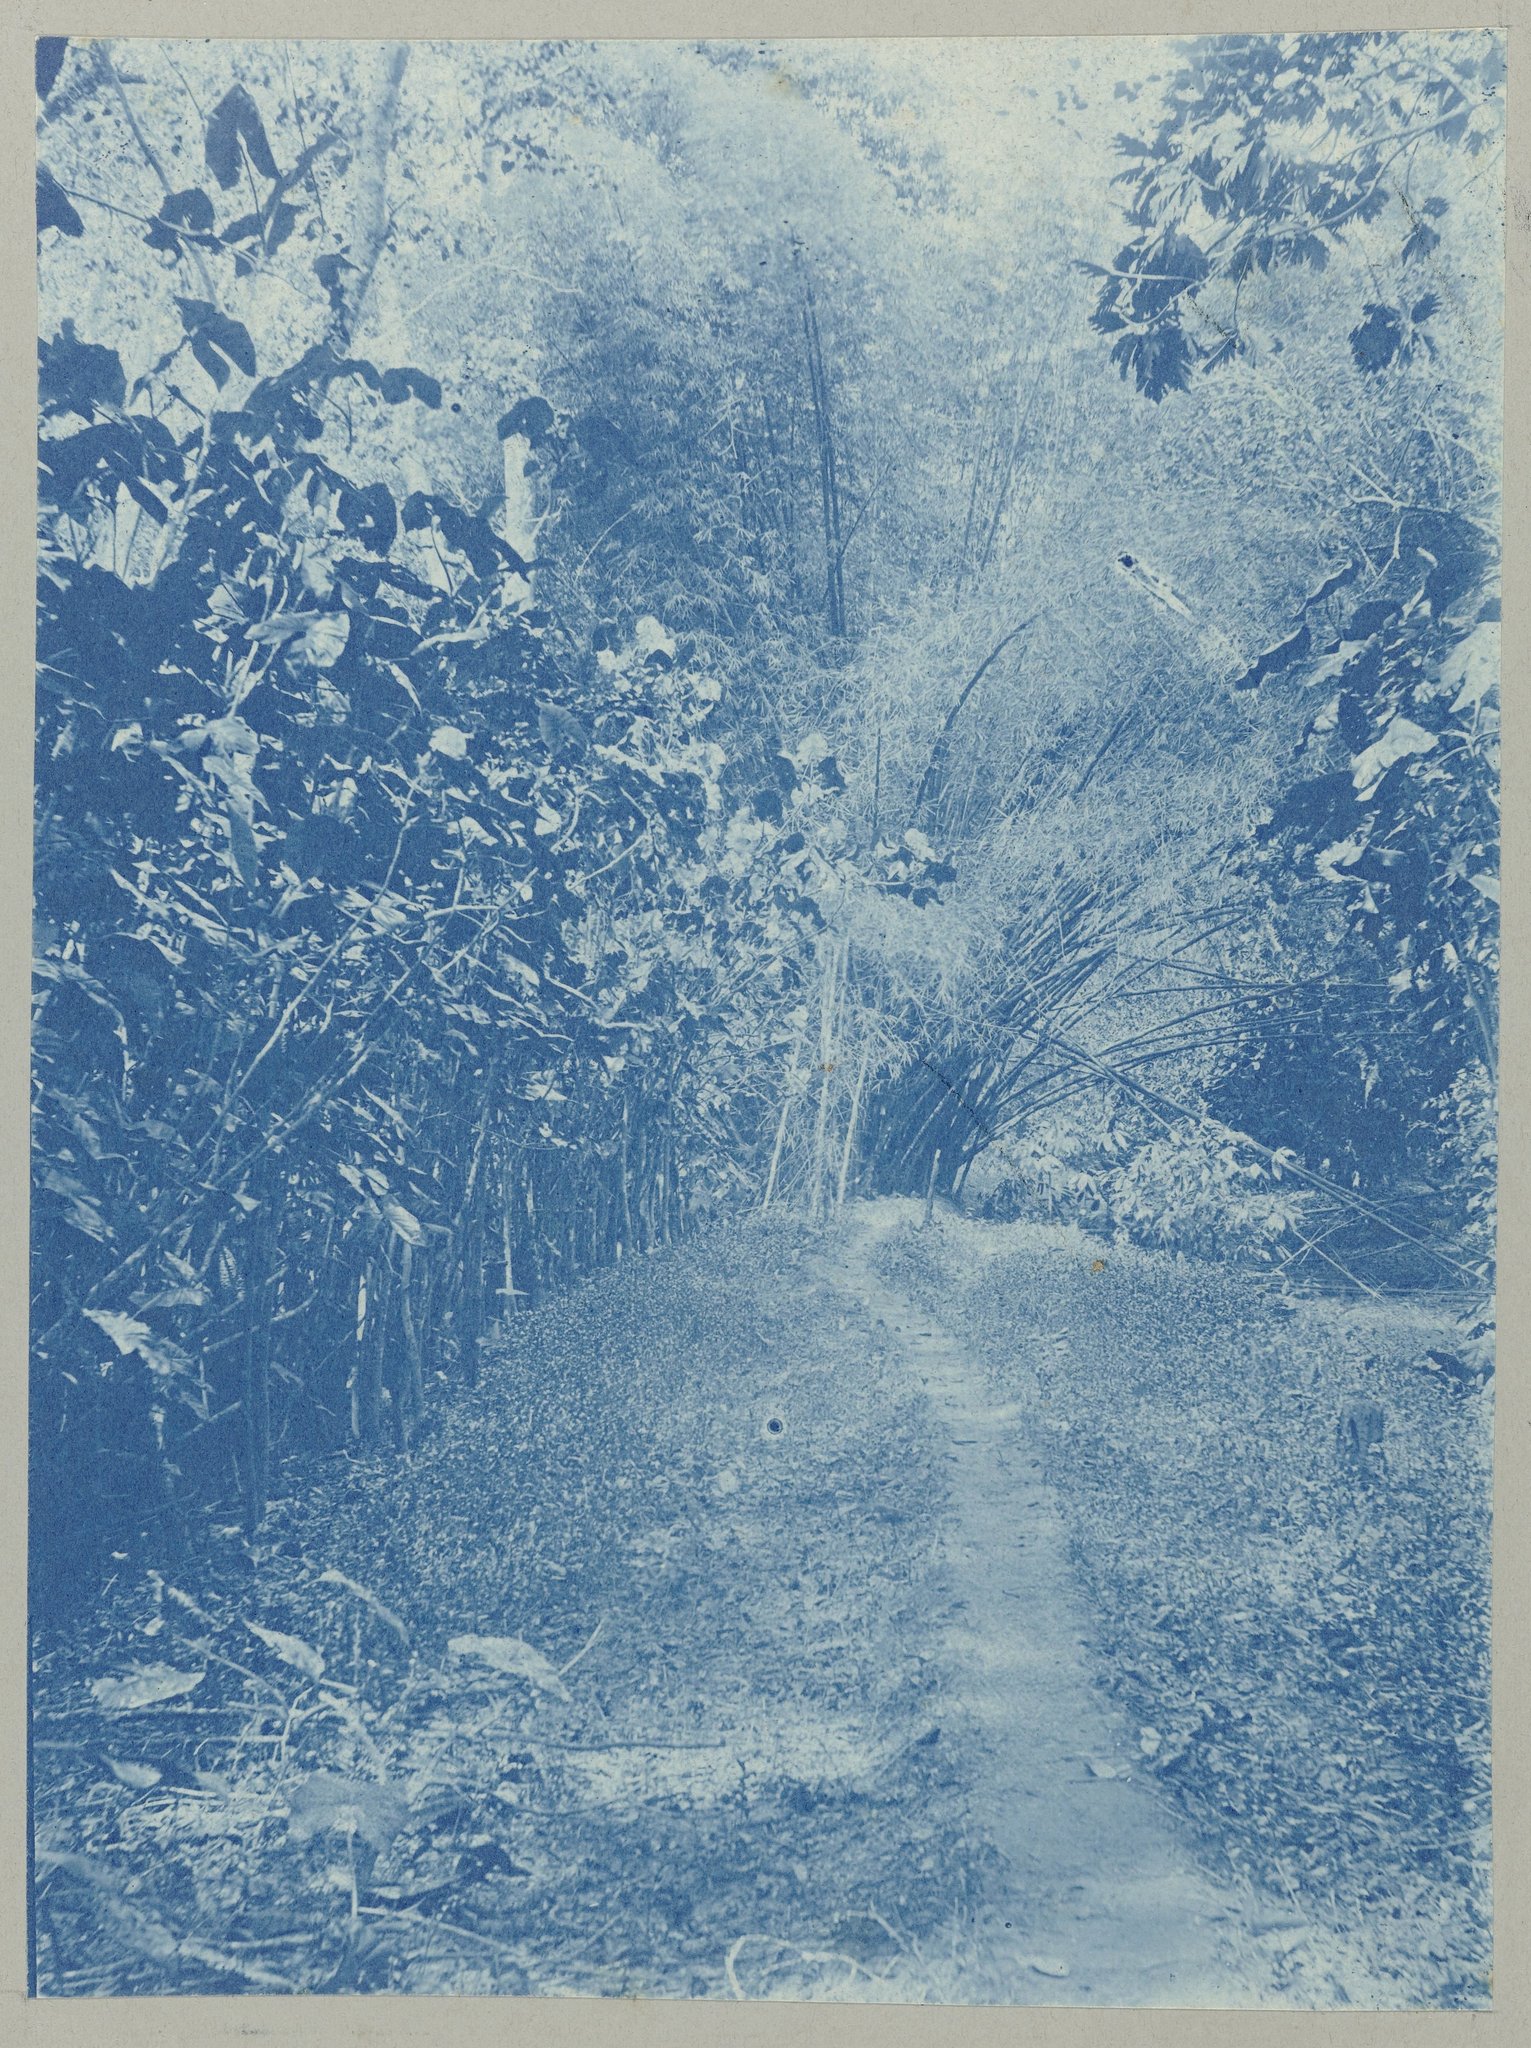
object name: photograph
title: Op den westdam van Tourtonne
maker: hendrik doijer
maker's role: engineer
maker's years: 1863-1925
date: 1903-1910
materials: photographic support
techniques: cyanotype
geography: suriname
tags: suriname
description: Plantengroei op de westdam van de plantage Tourtonne. Onderdeel van het fotoalbum Souvenir de Voyage (deel 2), over het leven van de familie Doijer in en rond de plantage Ma Retraite in Suriname in de jaren 1903-1910.